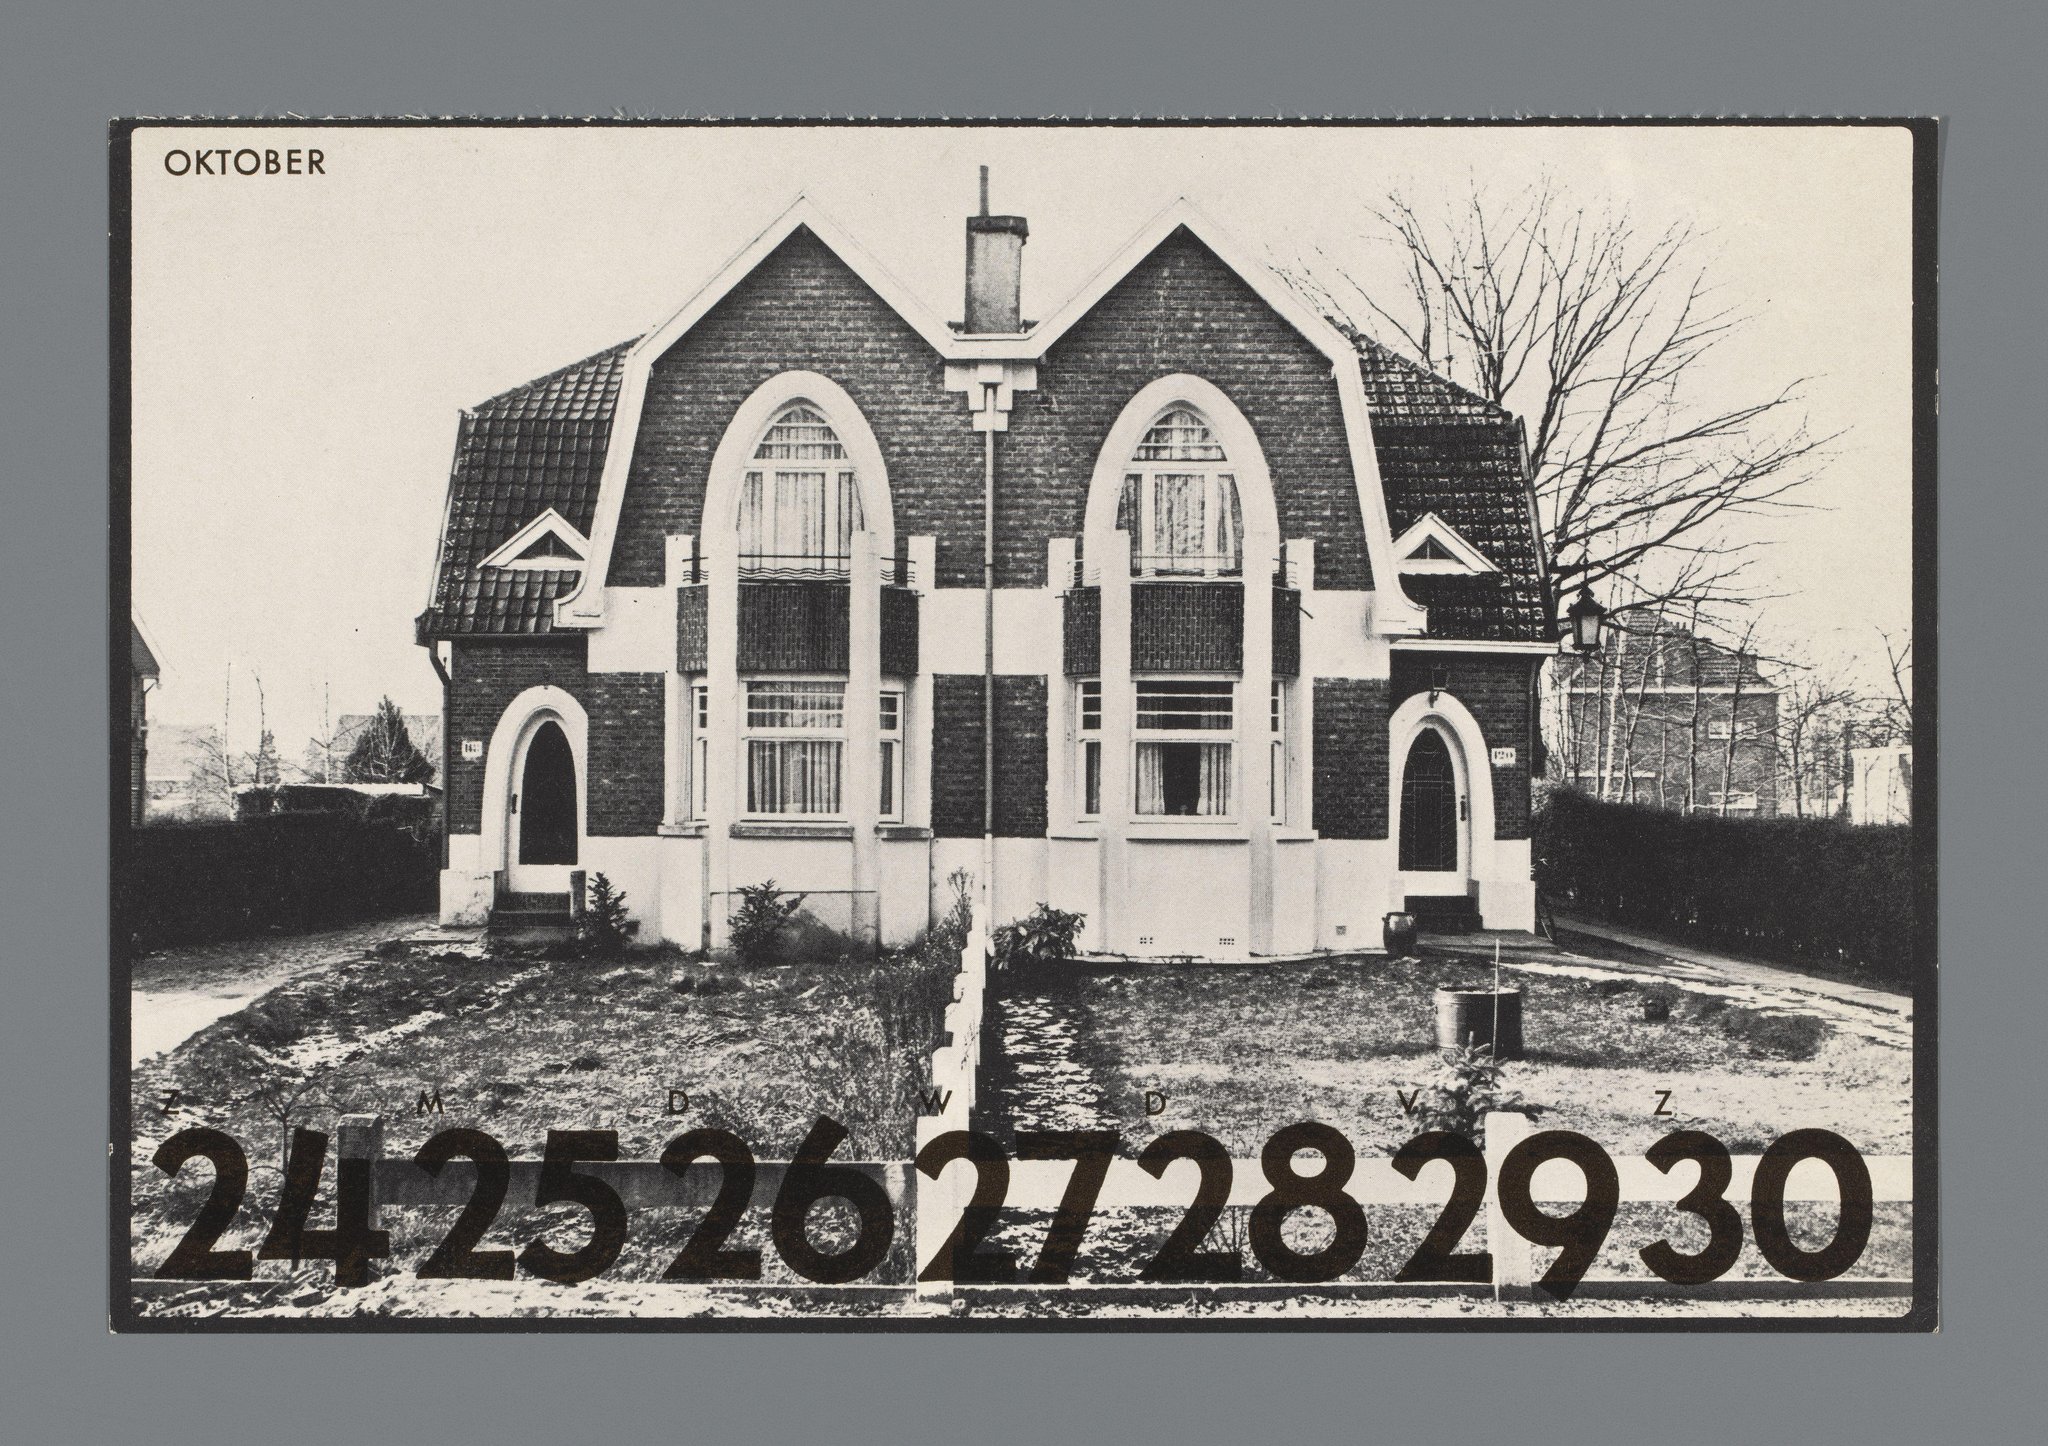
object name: photograph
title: België. Huizen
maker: Anonymous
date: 1900-1950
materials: paper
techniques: offset printed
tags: belgium